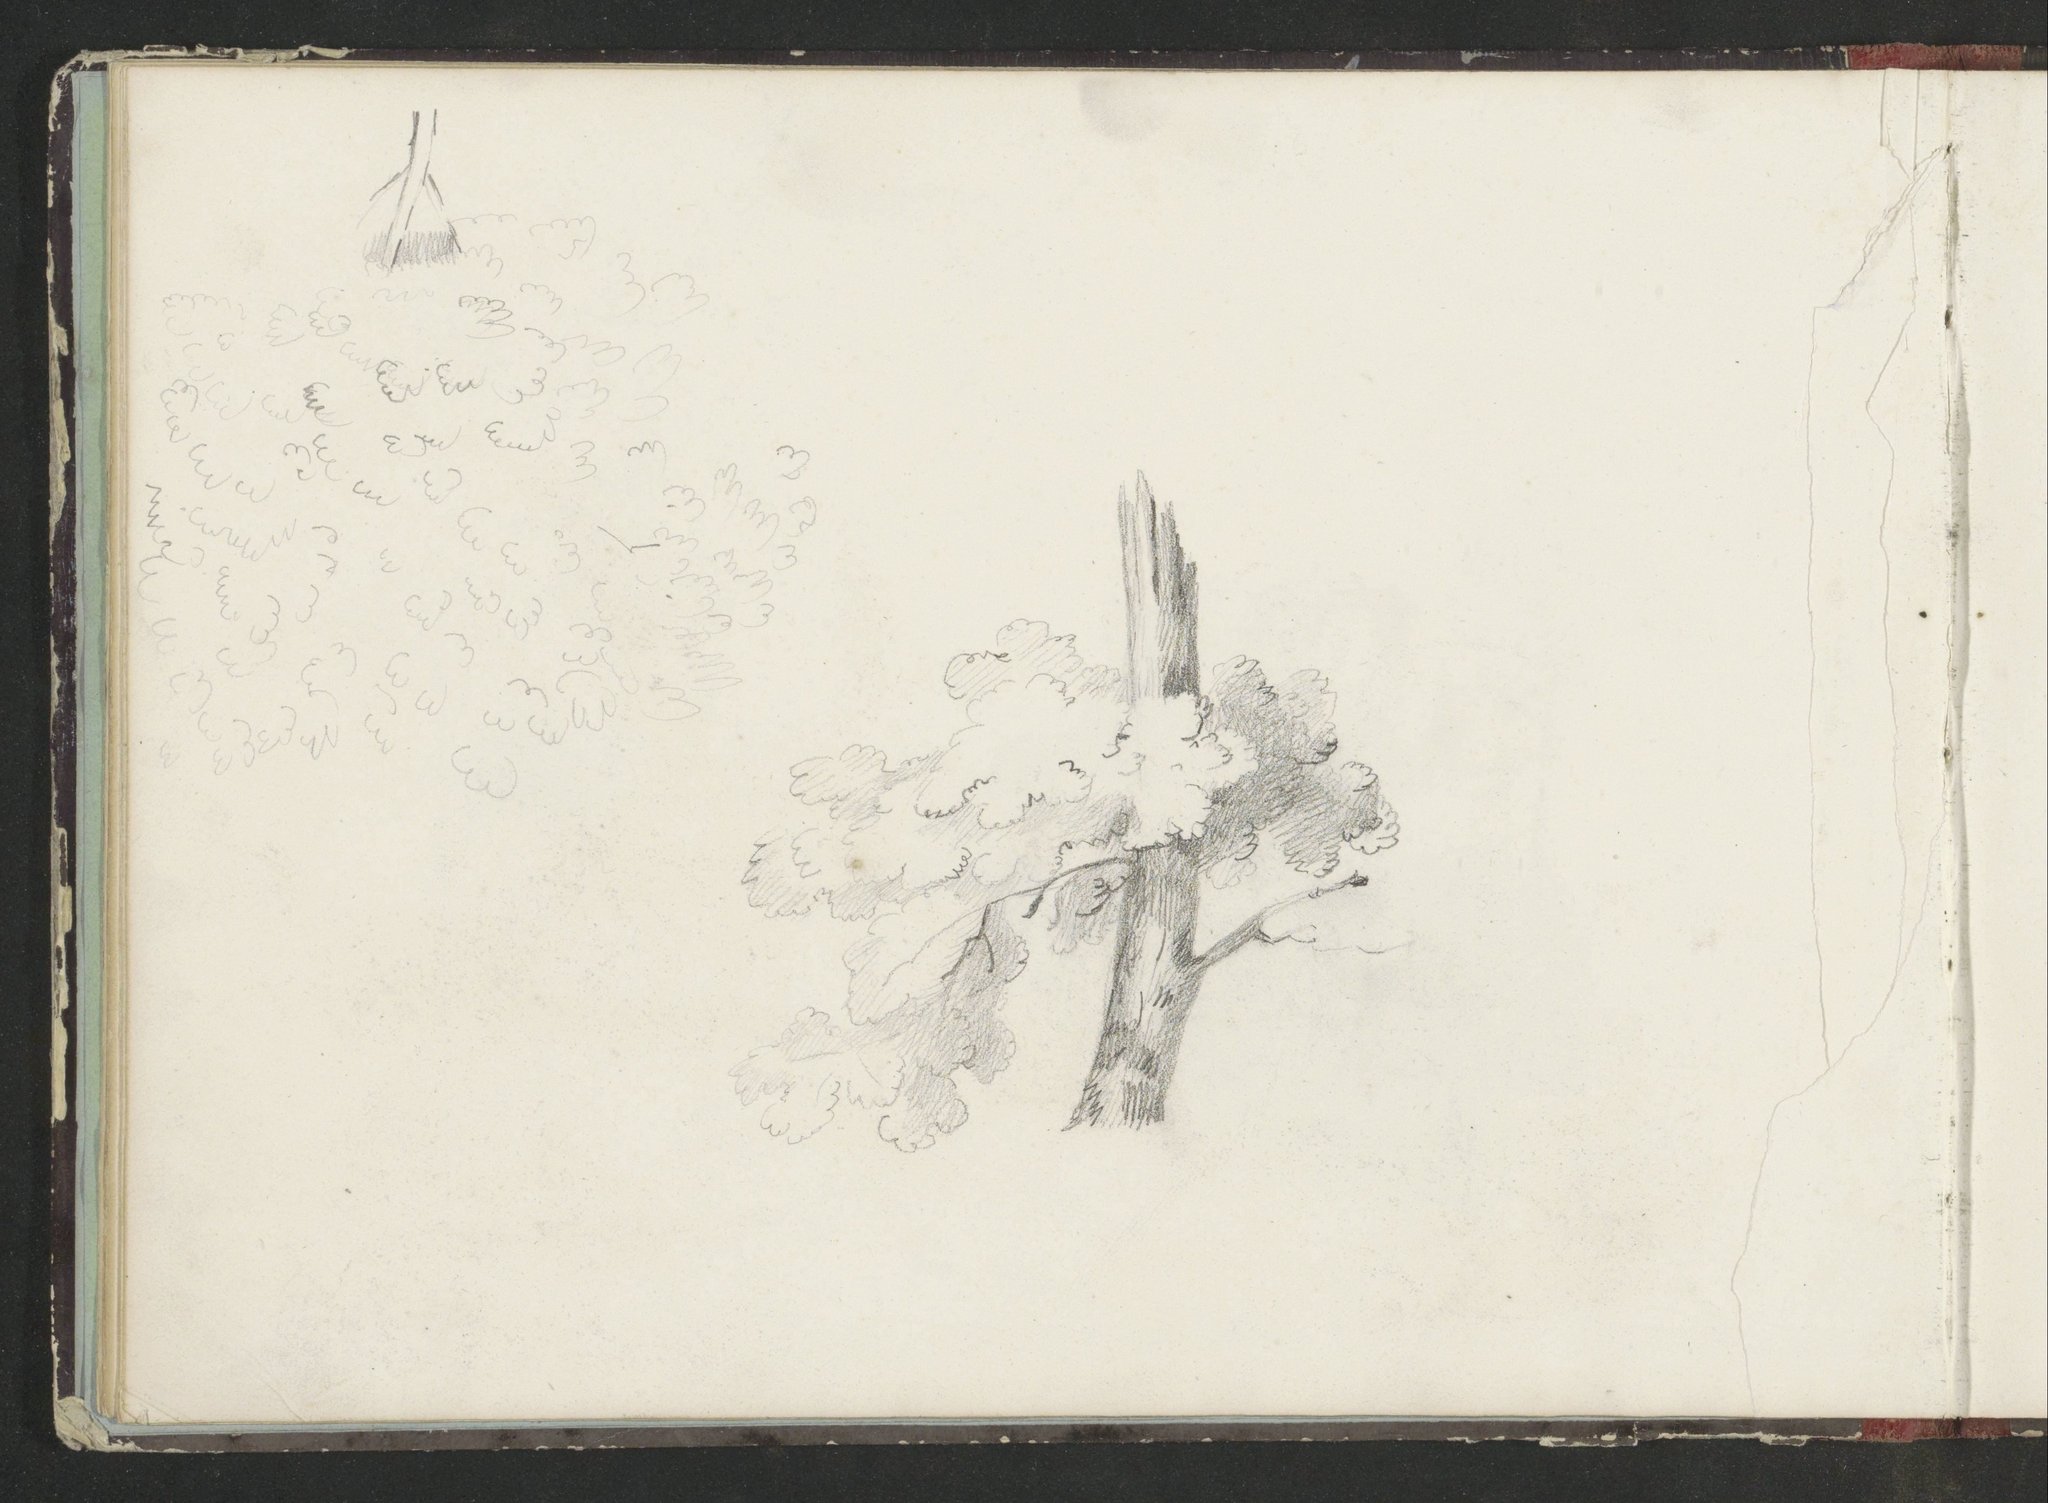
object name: sketchbook leaf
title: Boomstam en bladeren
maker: Anonymous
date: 1819-1870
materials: paper, pencil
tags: trees (+ leaf), trees (+ stem, trunk)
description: Blad 8 verso uit een schetsboek met 39 bladen.